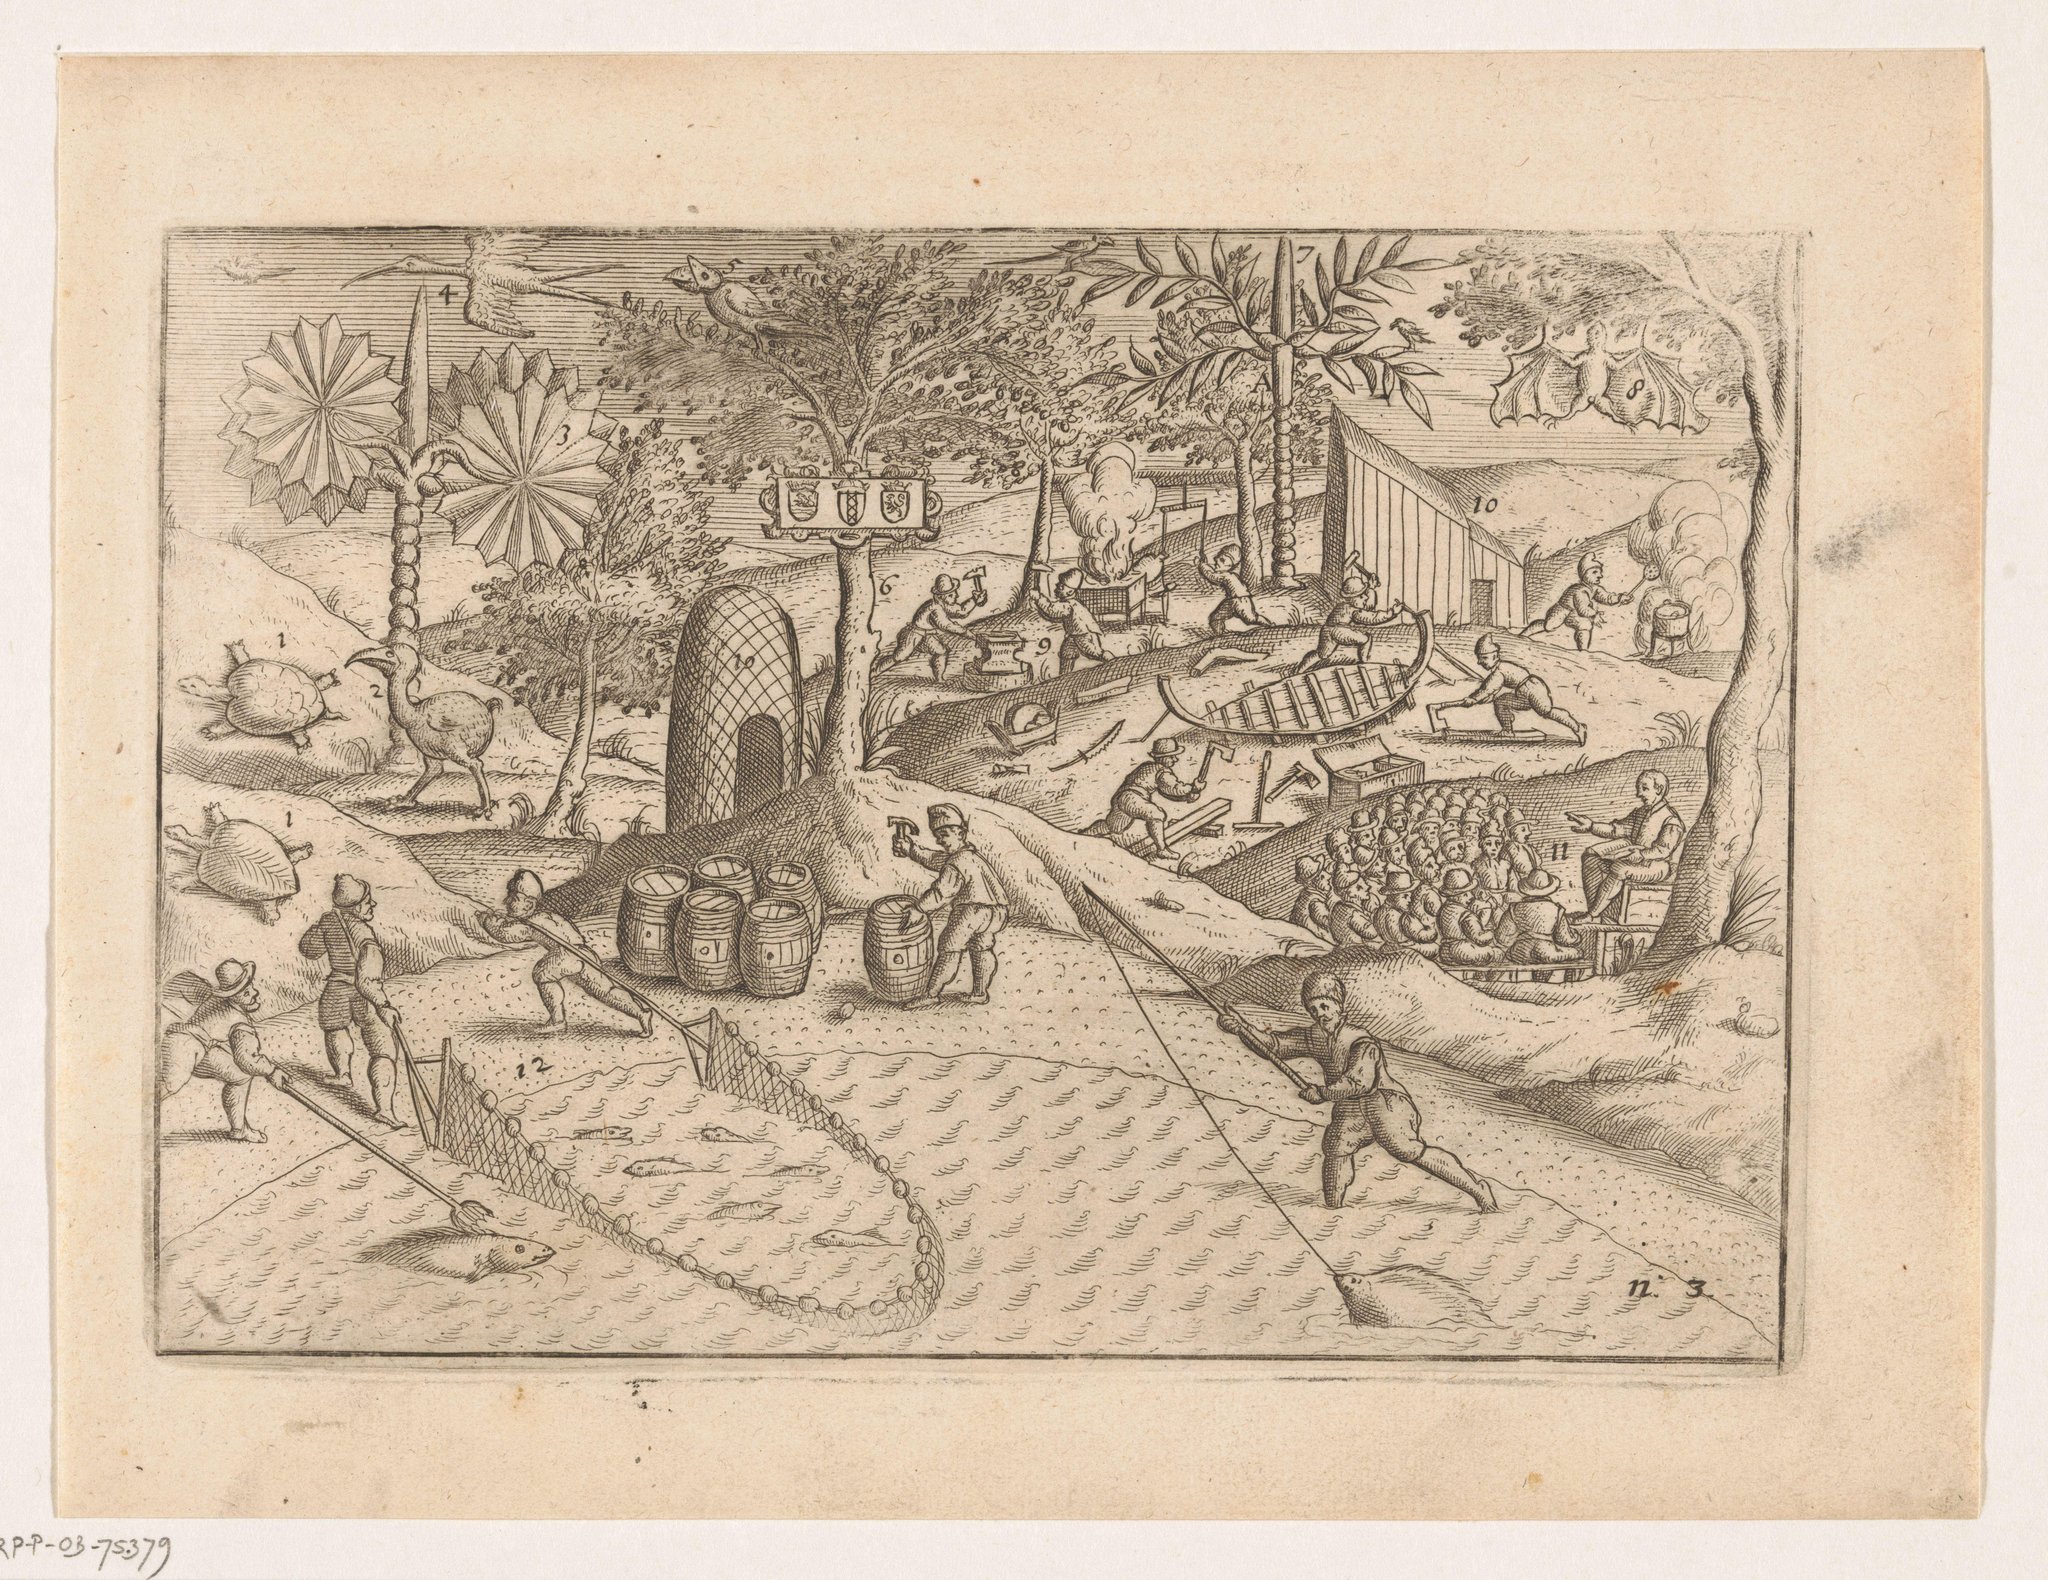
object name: print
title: Kamp van de Nederlanders op Mauritius, 1598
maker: Anonymous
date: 1600-1601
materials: paper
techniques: engraving, etching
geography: northern netherlands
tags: mayor, amsterdam, other birds: dodo, landscapes in tropical and sub-tropical regions, exploration, expedition, voyage of discovery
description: Gebruikt als illustratie eerst in: Journael ofte Dagh-register, inhoudende een waerachtigh verhael ... vande reyse, ghedaen door de acht schepen van Amsterdamme, onde 'tbeleydt van Iacob Cornelisz. Neck. als Admirael, ende VVybrandt van VVarvvijck, als Vice-admirael, van Amsterdam gheseylt inden jare 1598, Cornelis Claes, Amsterdam [1600], plaat No. 2. In deze staat gebruikt in: Oost-Indische ende West-Indische voyagien, Michiel Colijn, Amsterdam 1619 en later in: Waerachtigh verhael van de Schipvaerd op Oost-Indien ghedaen by de acht Schepen in den jare 1598 van Amsterdam uyt-ghezeylt, onder 't beleyd van den Admirael Jacob Cornelissoon van Neck, ende Vice-Admirael Wybrand van Warwijck. Opgenomen in: I. Commelin, Begin ende voortgangh, van de Vereenighde Nederlantsche Geoctroyeerde Oost-Indische Compagnie, J. Janssonius, Amsterdam 1646. Genummerd: 3.